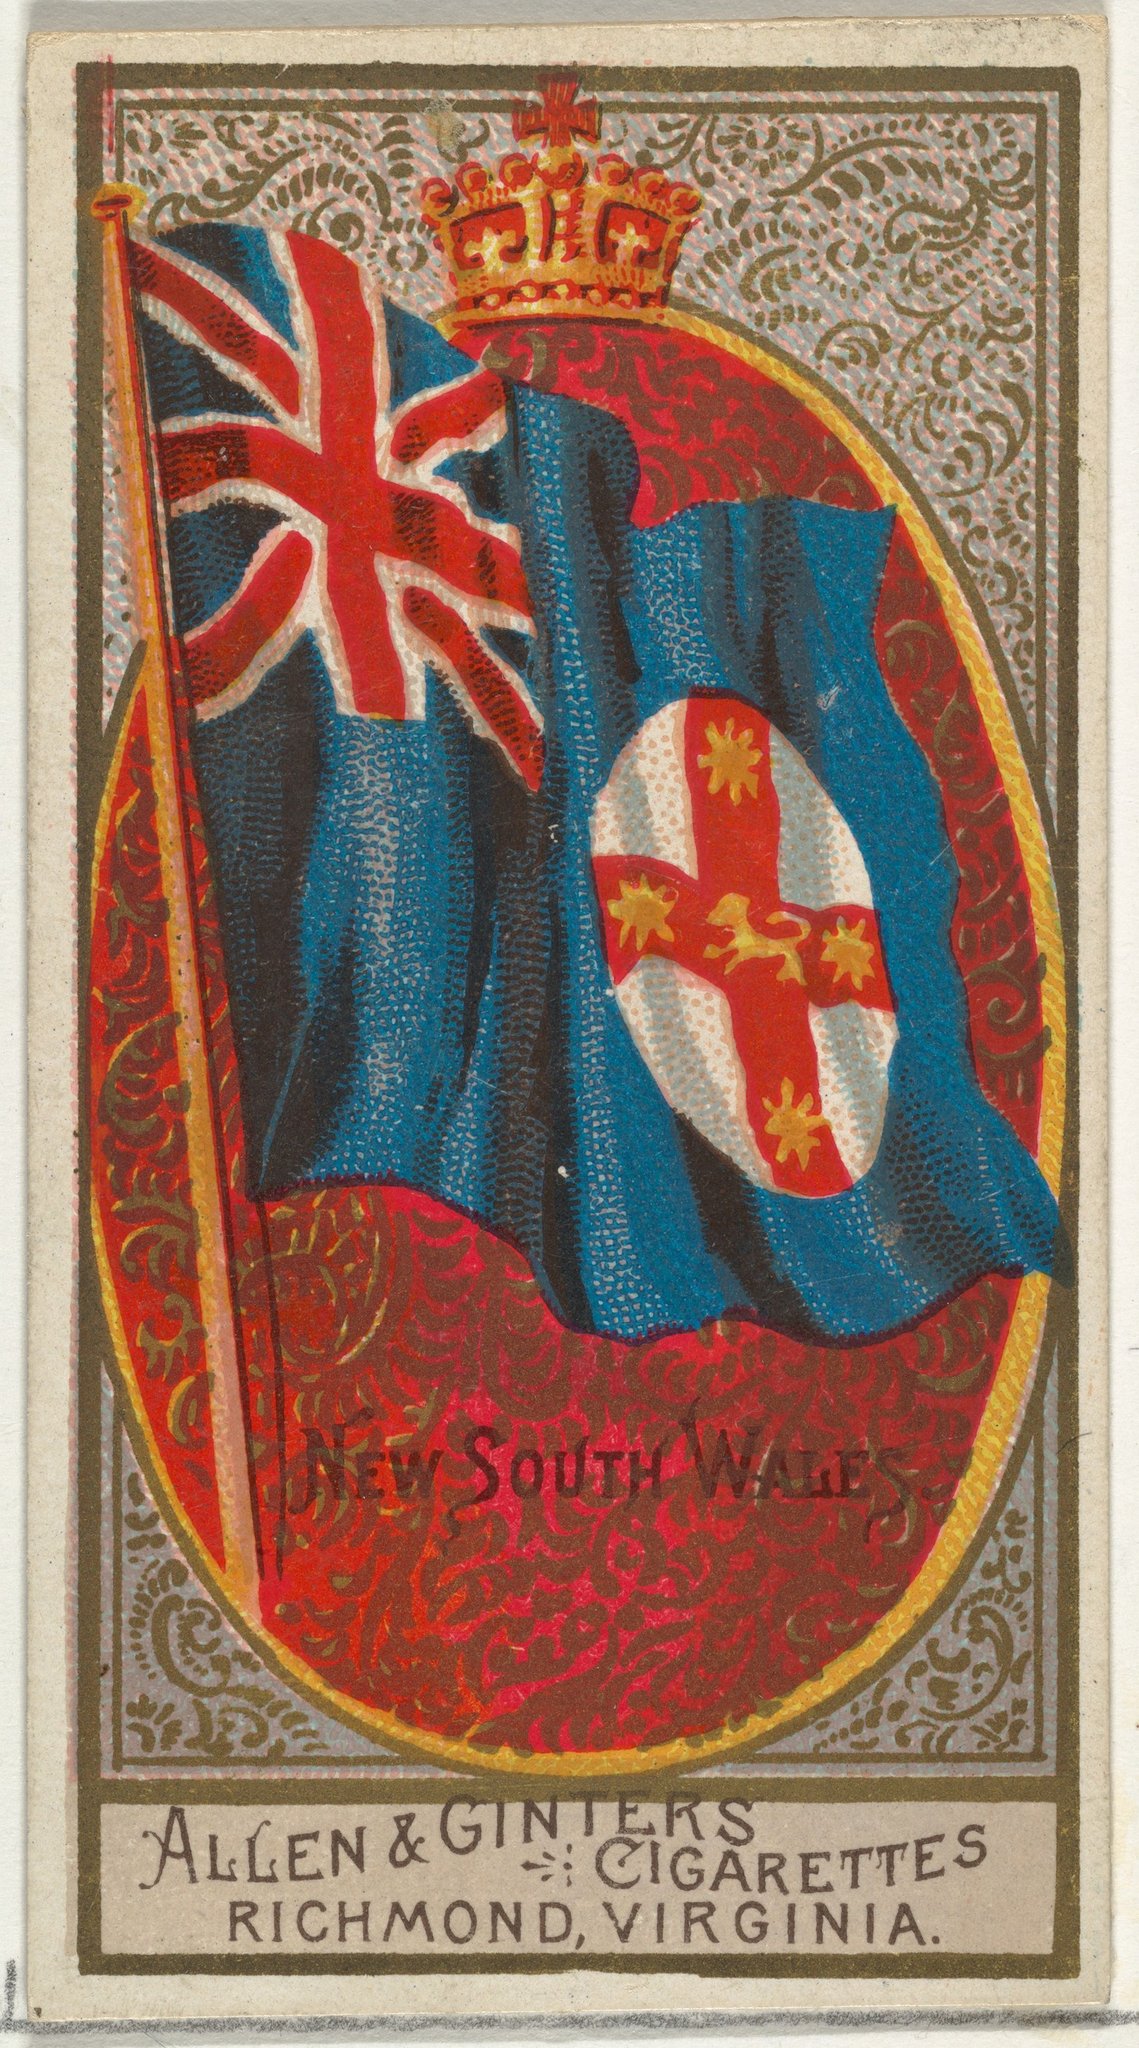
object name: print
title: New South Wales, from Flags of All Nations, Series 2 (N10) for Allen & Ginter Cigarettes Brands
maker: allen & ginter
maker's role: publisher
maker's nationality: american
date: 1890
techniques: color lithograph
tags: flags